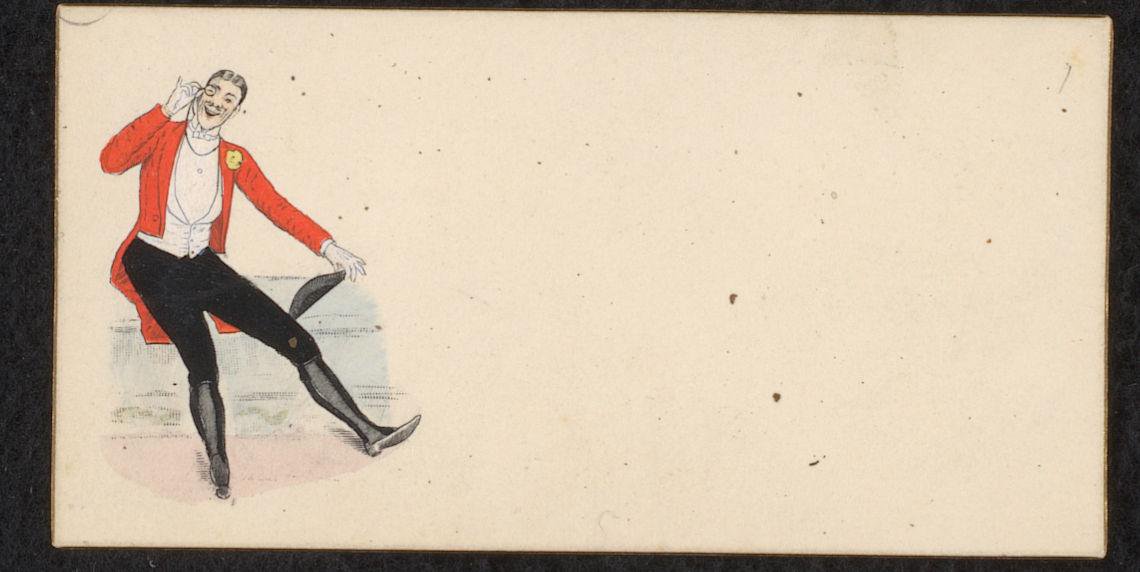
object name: photomechanical print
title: Man in rokkostuum met monocle en hoed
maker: Anonymous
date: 1870-1920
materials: paint, paper, watercolor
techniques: hand coloring, printing block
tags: party clothes, festive attire, monocle, single lorgnette, head-gear: hat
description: Mogelijk een (oningevulde) plaatskaart voor een diner. Bij gebrek aan gegevens over de vervaardiger is voor de bepaling van de rechten van dit object gebruik gemaakt van de vervaardigingsdatum.